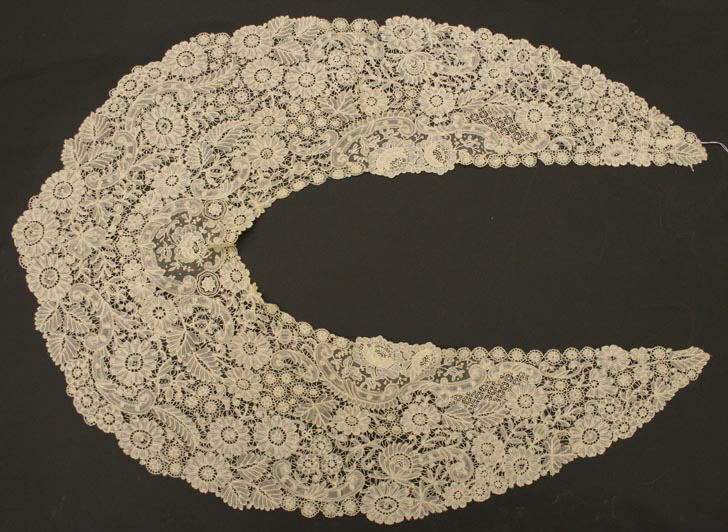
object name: collar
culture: belgian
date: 1867-1900